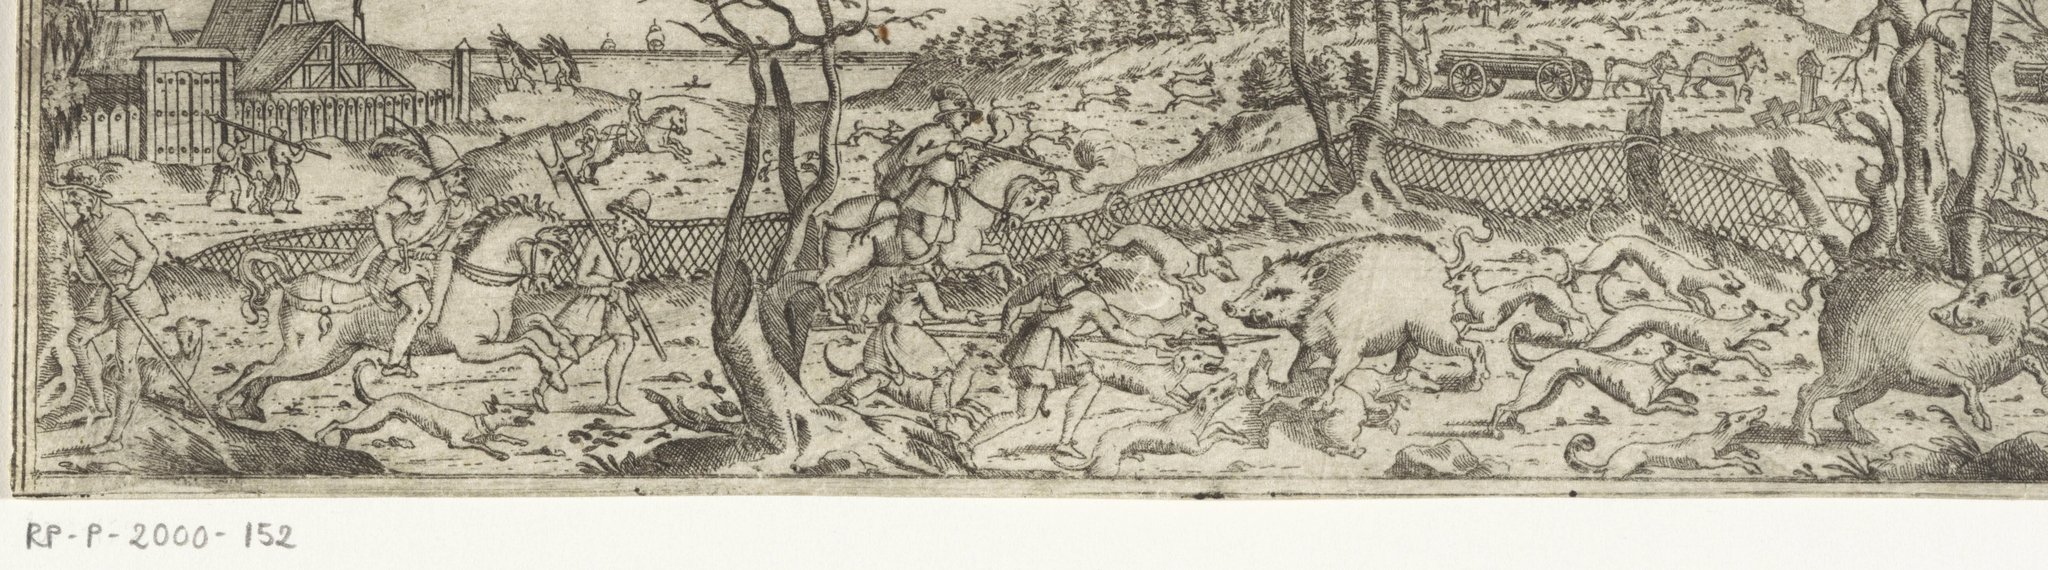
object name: print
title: Novenber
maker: Anonymous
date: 1554-1641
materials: paper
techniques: etching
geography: netherlands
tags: november and its 'labours' (+ with zodiacal signs)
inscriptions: collector's mark: Lugt 2228, collector's mark: Lugt 2760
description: De bezigheden in de maand november. Vooraan de zwijnenjacht. Op de achtergrond rijden karren, getrokken door paarden. In de lucht het dierenriemteken Boogschutter.